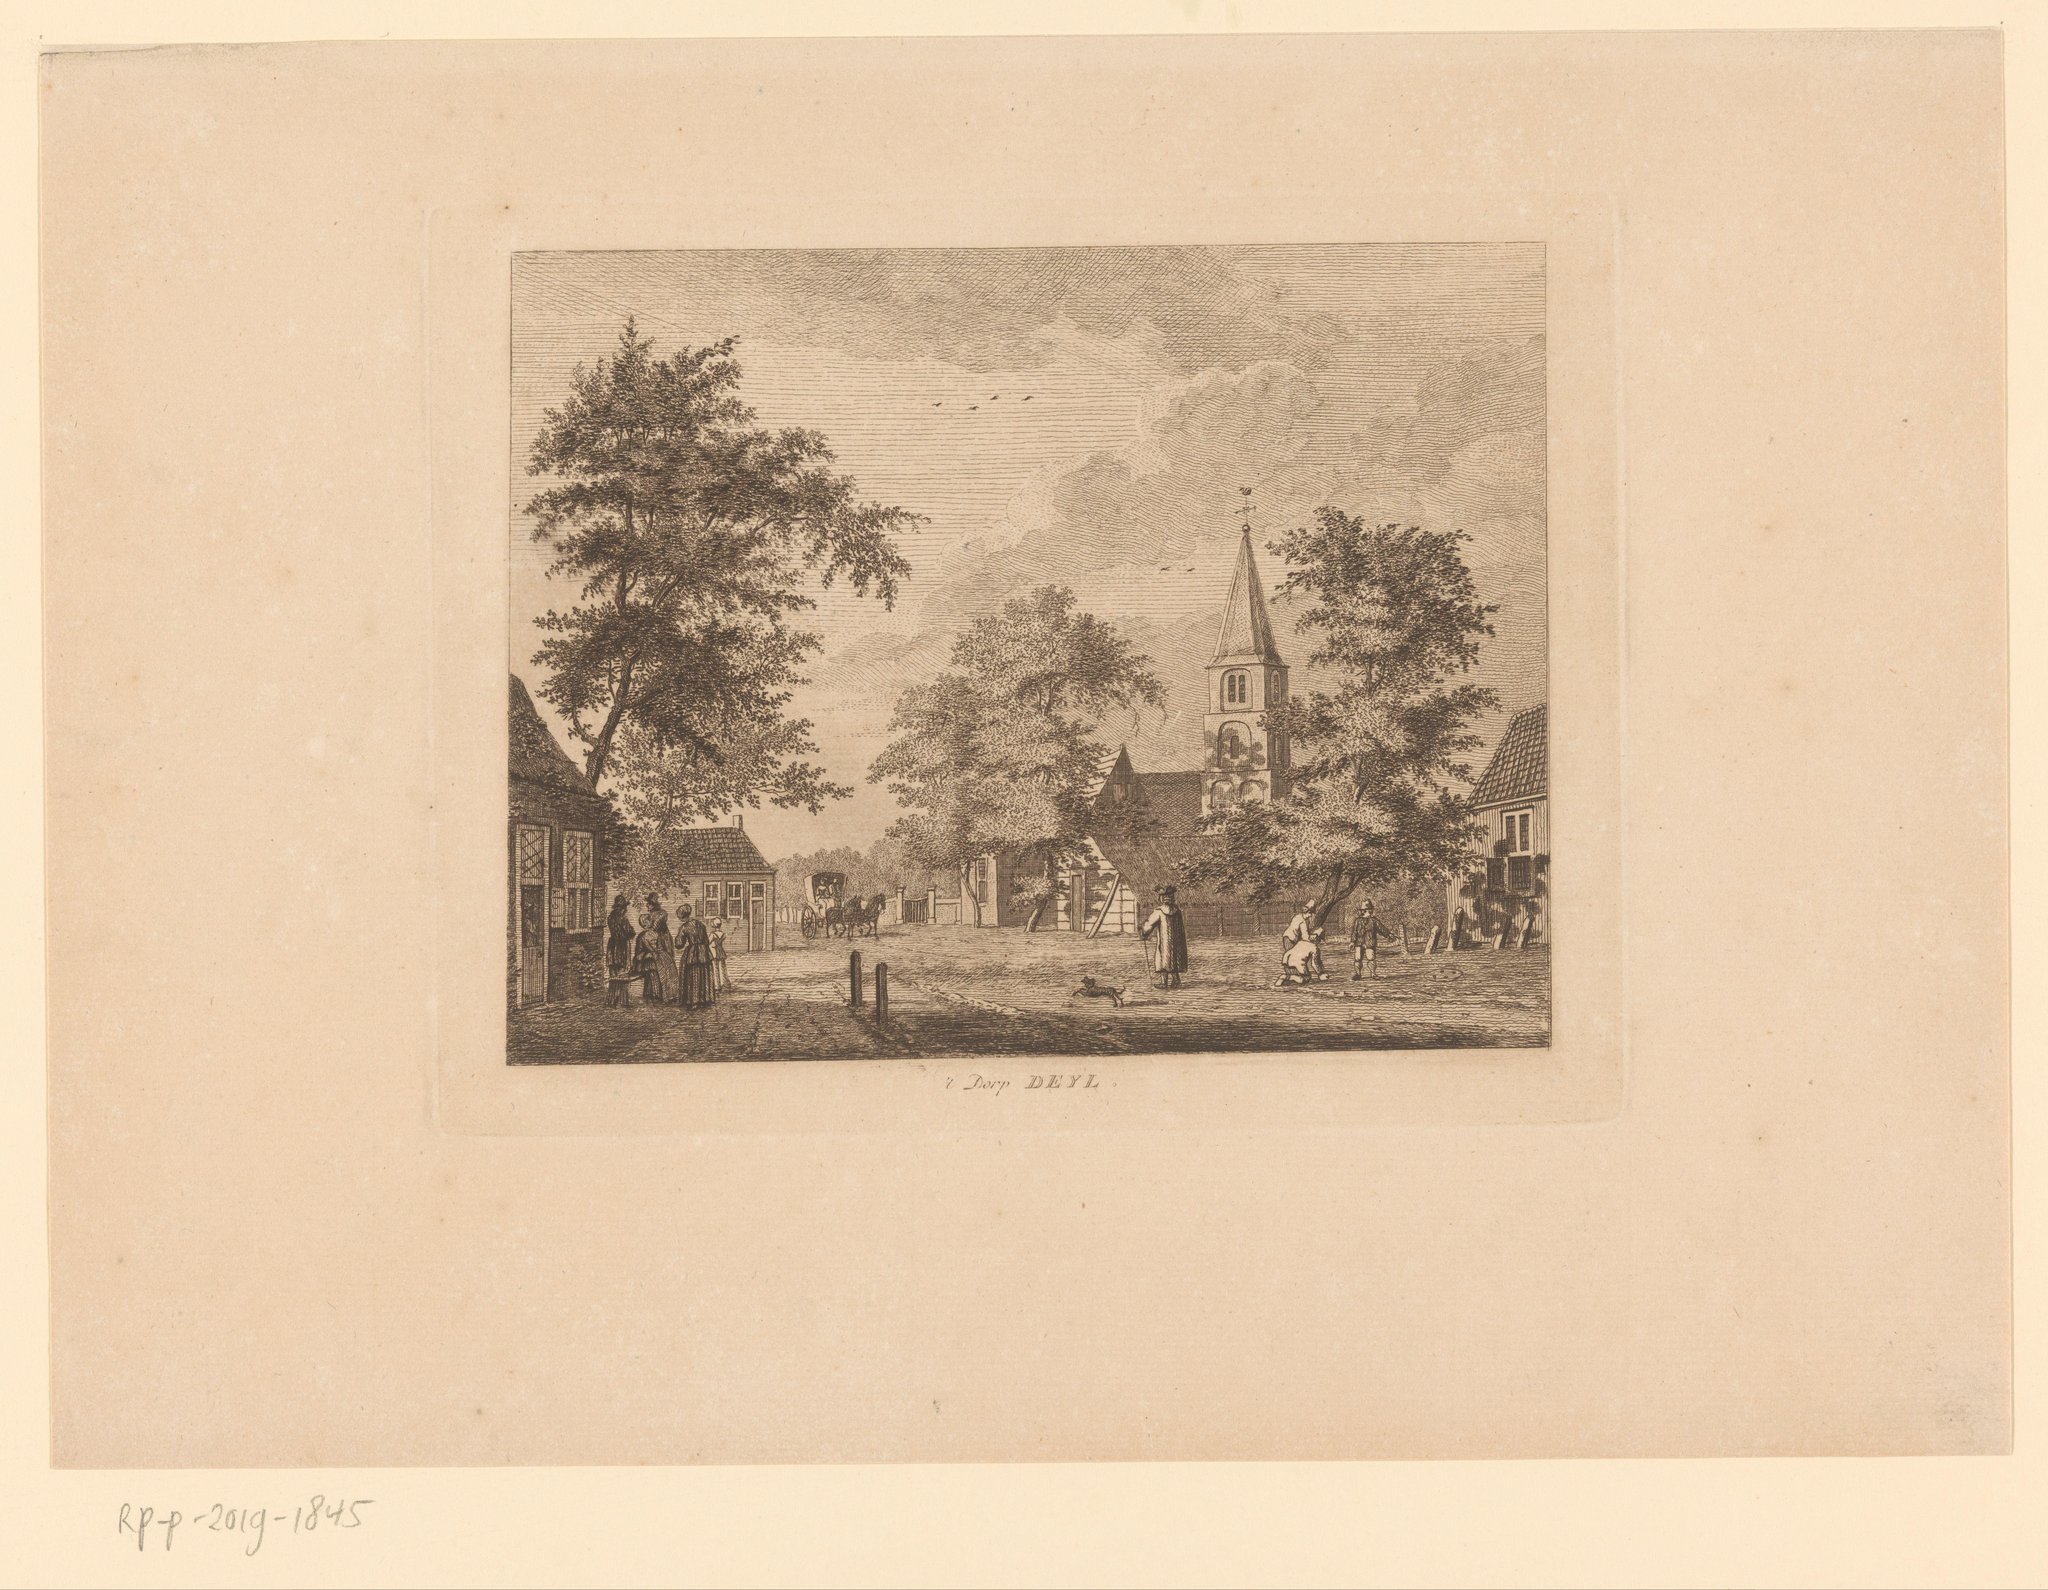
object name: print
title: Gezichten voorname Hollandse dorpen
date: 1770-1800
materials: paper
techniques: etching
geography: amsterdam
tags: church (exterior), village (+ city(-scape) with figures, staffage)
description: Prent mogelijk uit: Gezichten voorname Hollandse dorpen. Amsterdam: Pierre Fouquet, s.a.